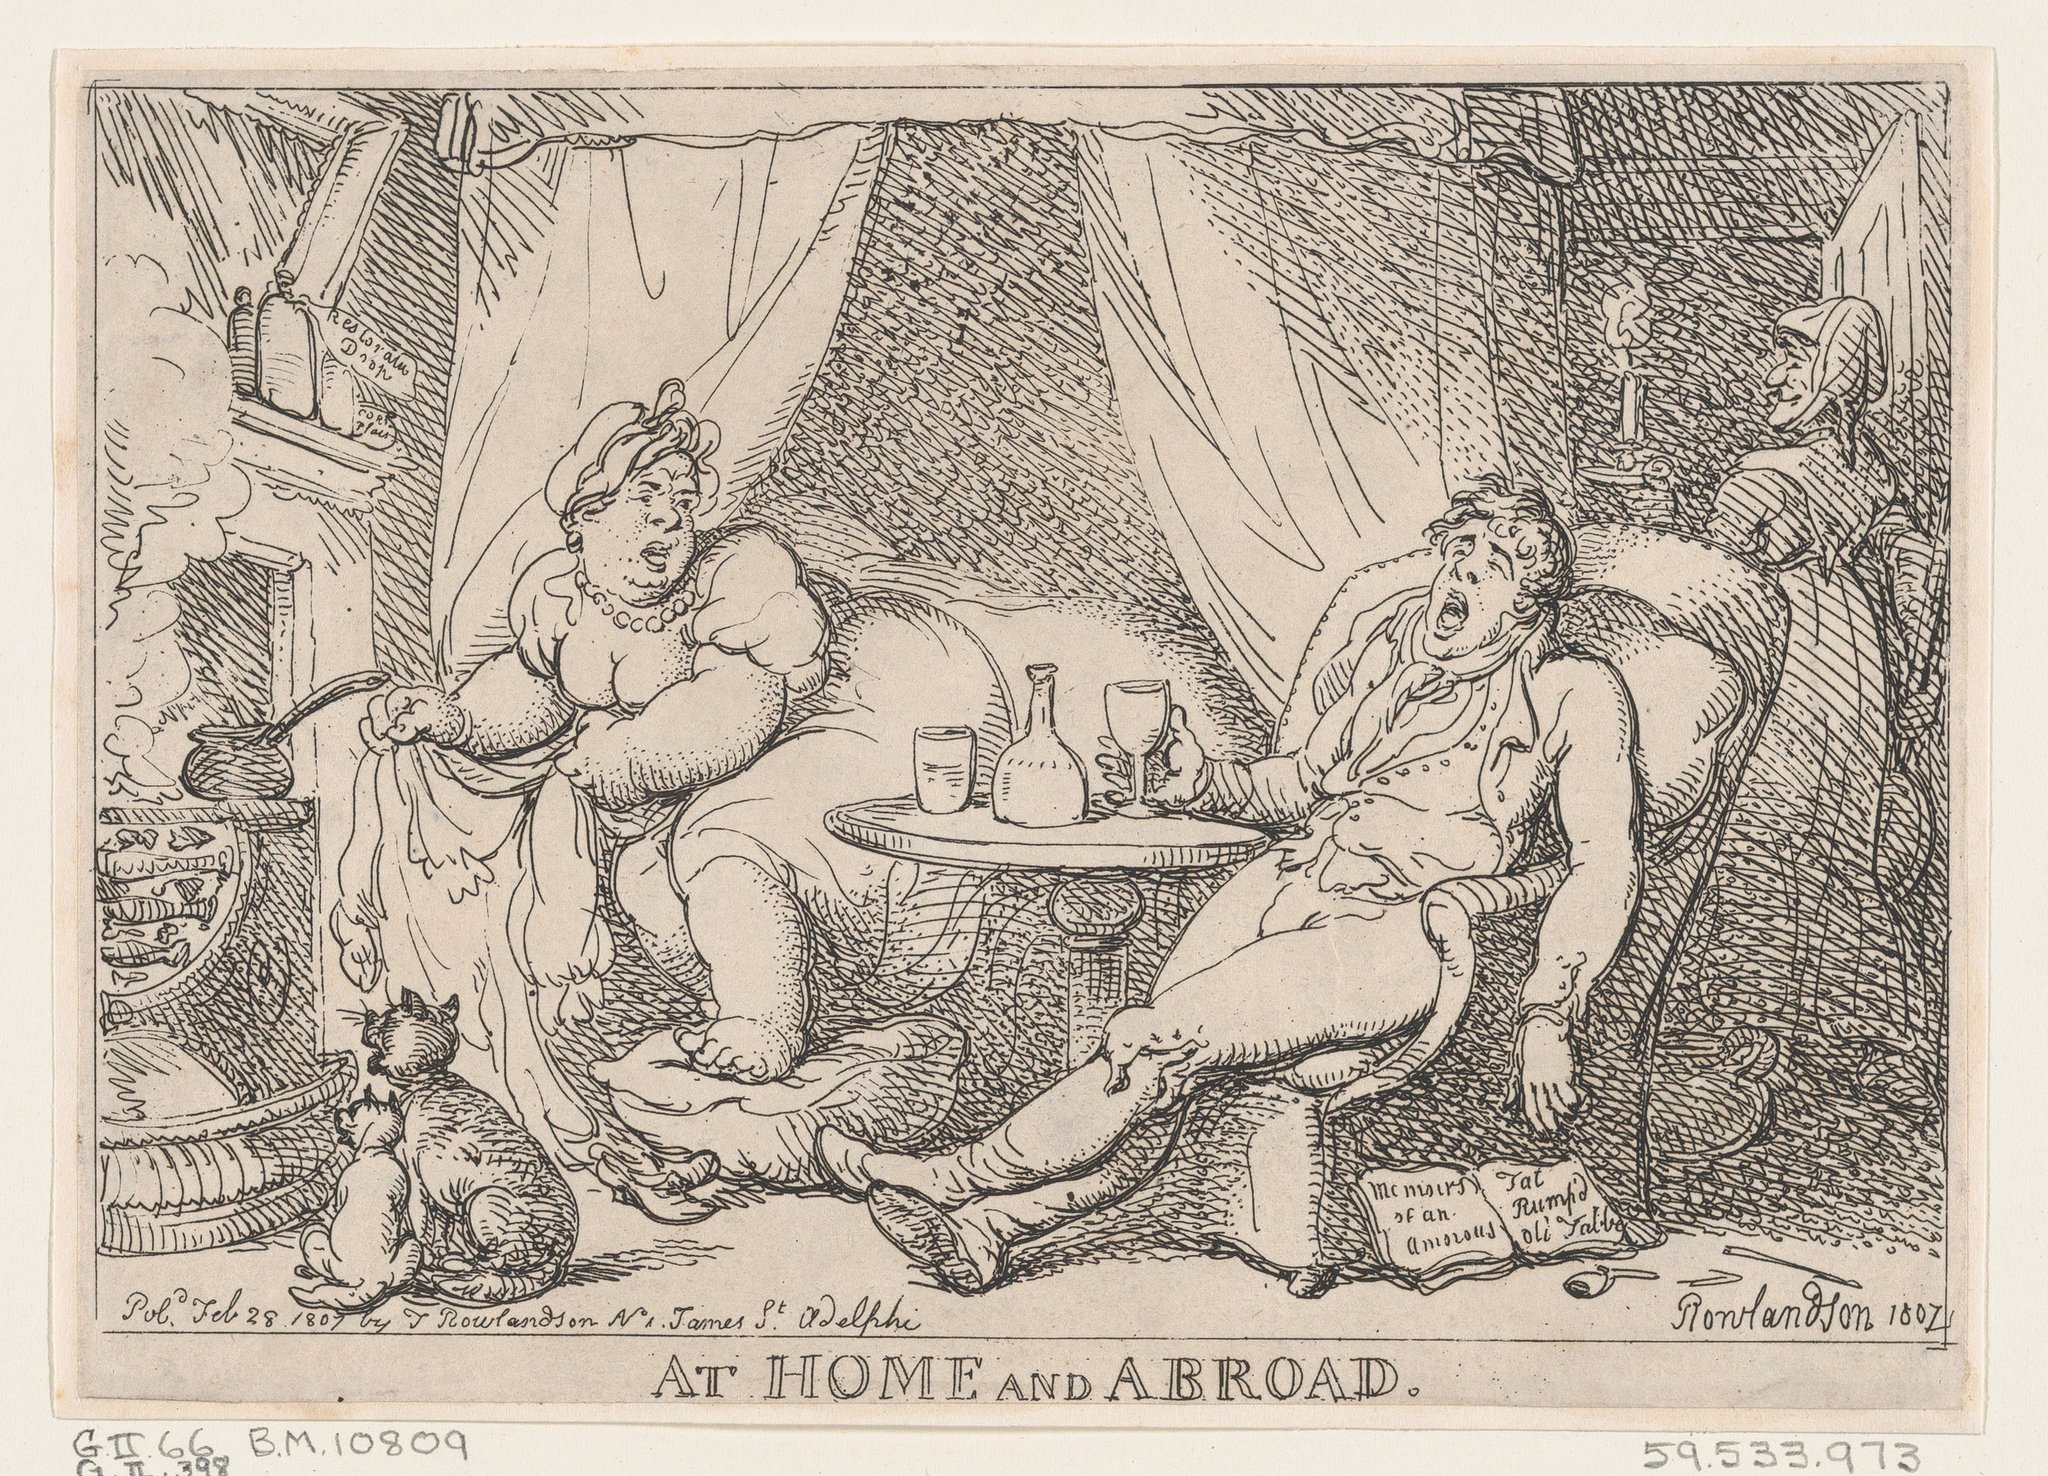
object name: print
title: At Home and Abroad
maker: thomas rowlandson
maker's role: artist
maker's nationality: british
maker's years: 1757-1827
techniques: etching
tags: satire,bedrooms,drunkenness,men,women,cats